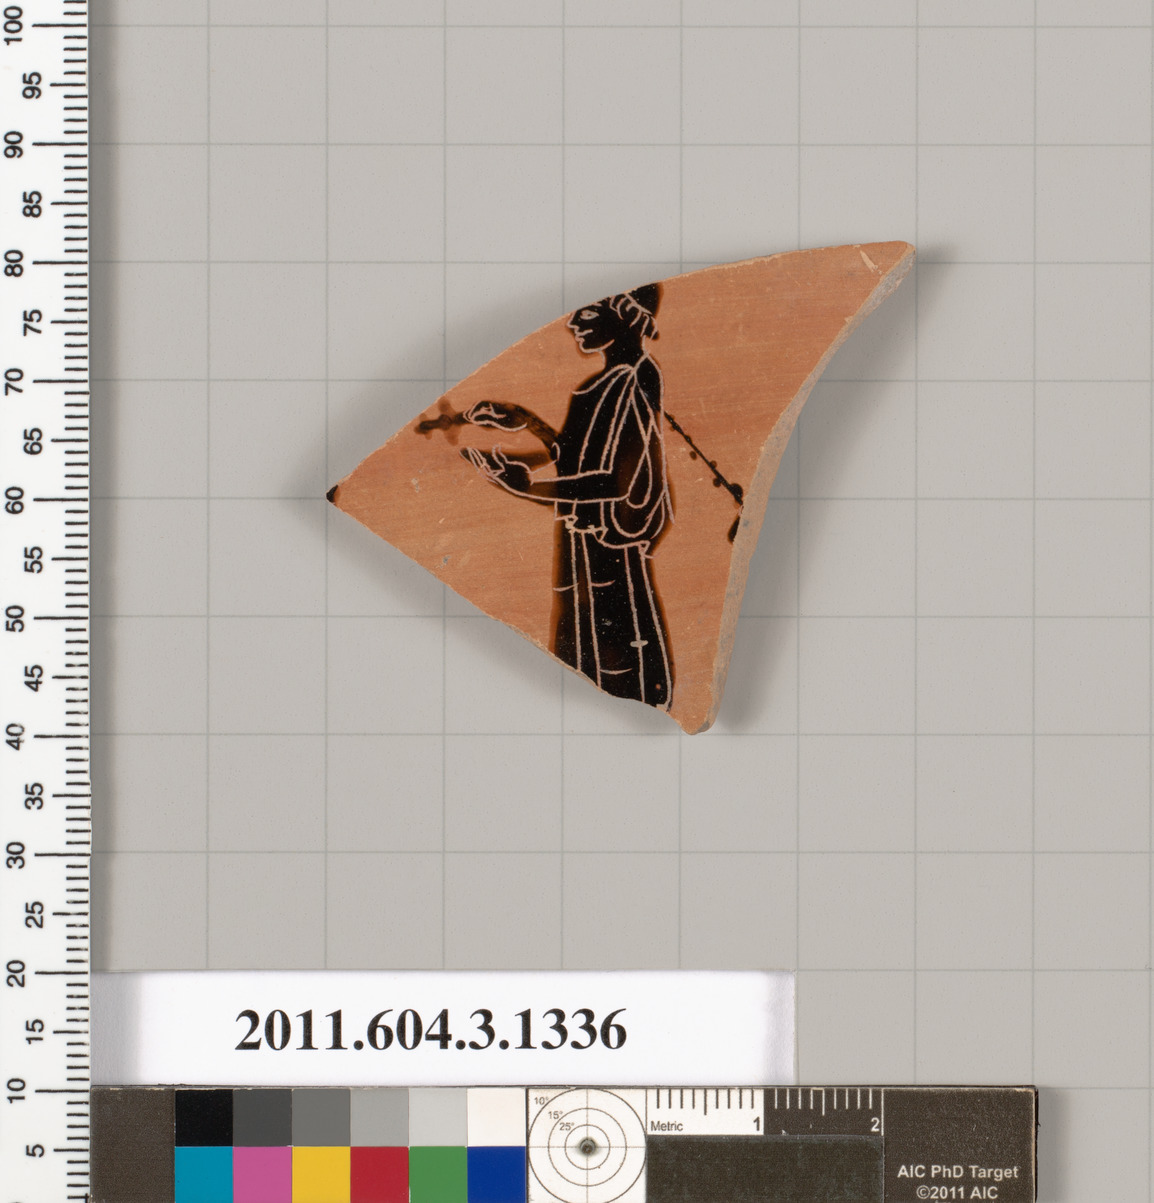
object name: skyphos fragment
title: Terracotta fragment of a skyphos (deep drinking cup)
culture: greek, attic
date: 500-468 BCE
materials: terracotta